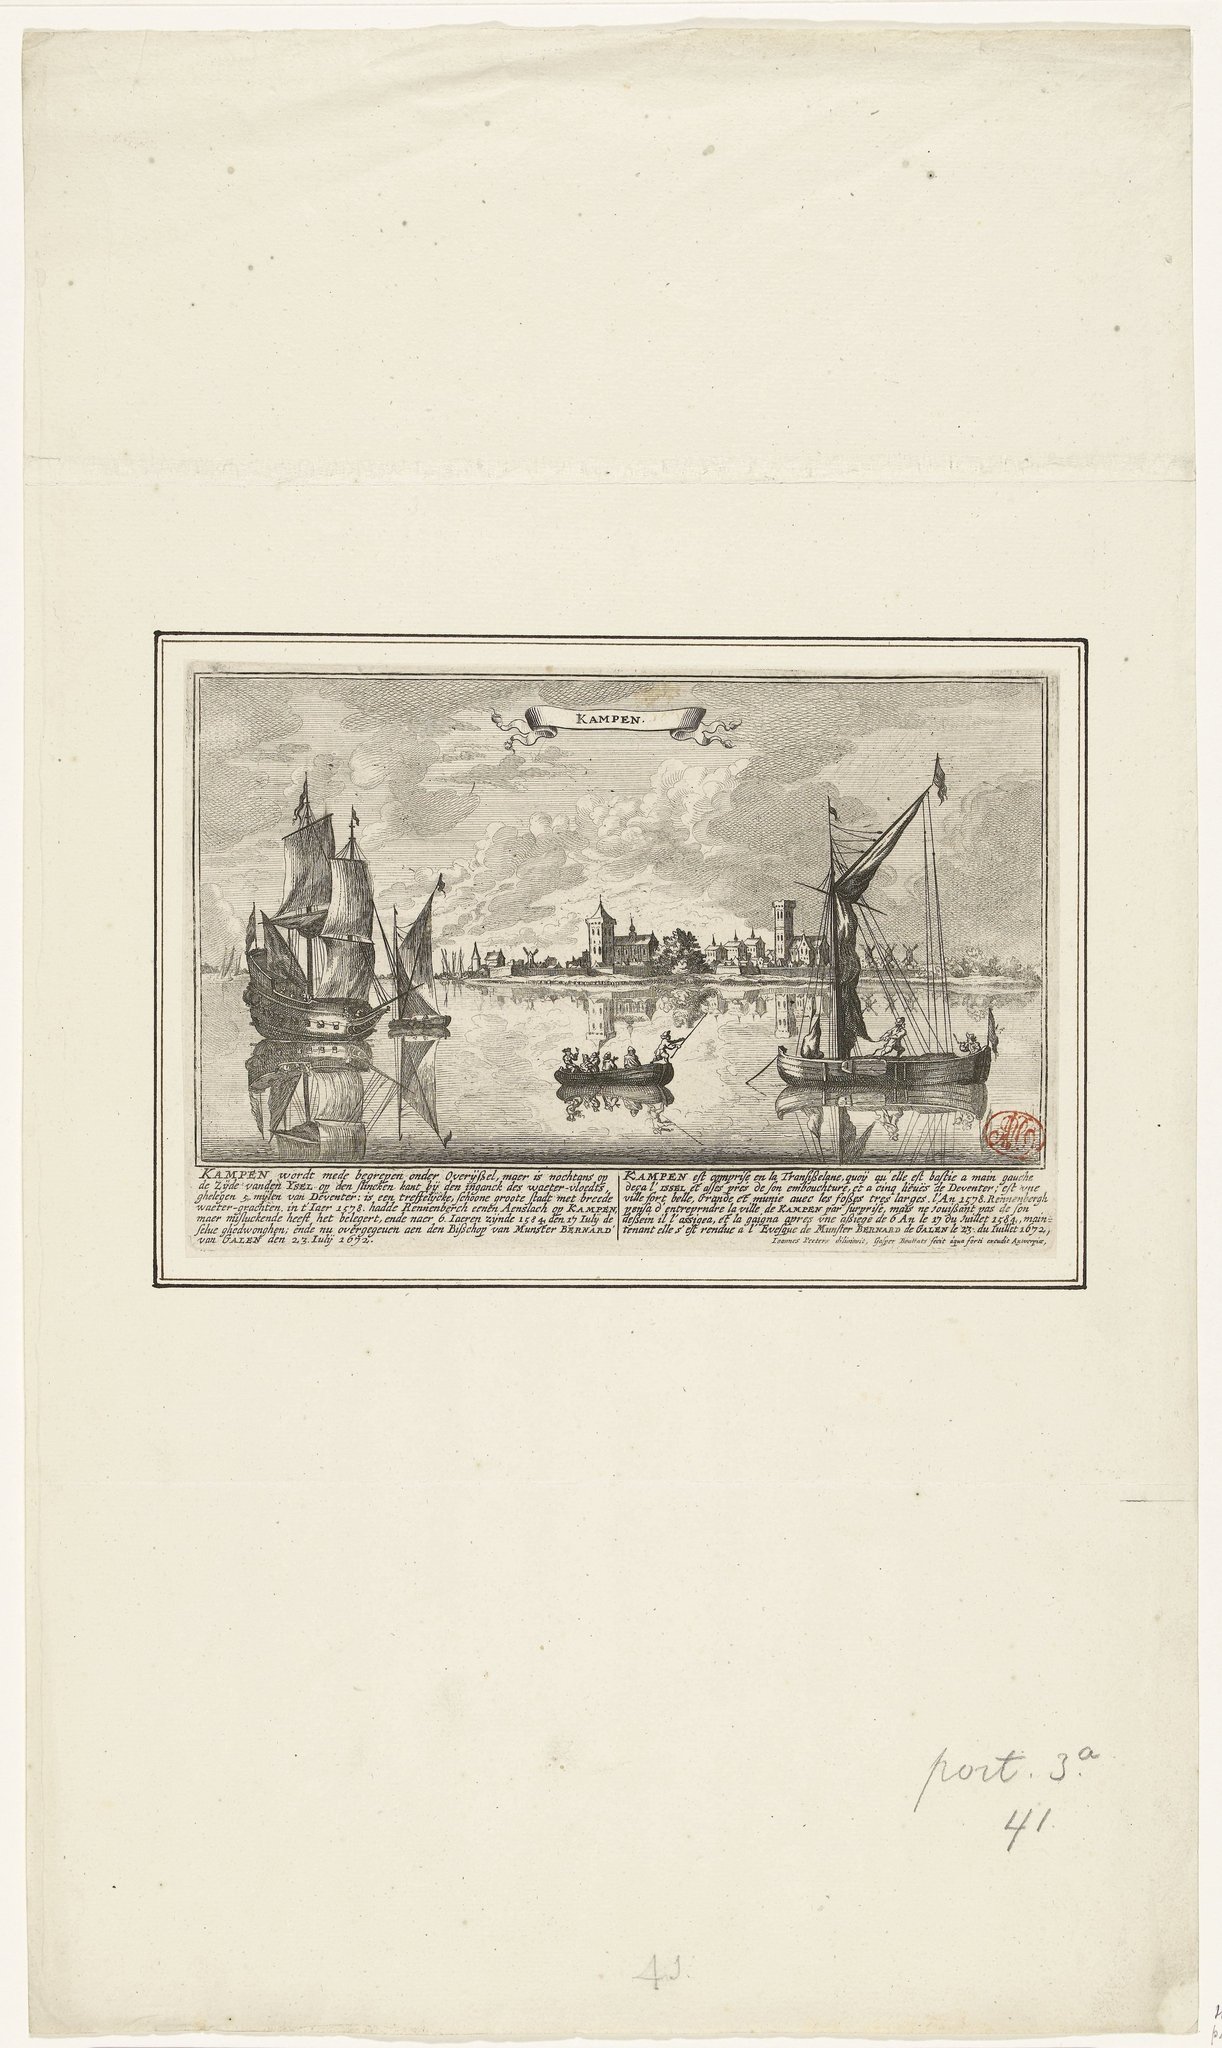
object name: print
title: Steden en vestigingen in de Republiek der Nederlanden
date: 1679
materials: paper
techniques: etching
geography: antwerp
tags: prospect of city, town panorama, silhouette of city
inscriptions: collector's mark: Lugt 195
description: Gezicht op de stad Kampen. Op de voorgrond, buiten de stadsmuren, de rivier De Ijsel met een galjoen en enkele zeilschepen. Boven het stadsgezicht een cartouche met de naam van de stad. De prent heeft een Nederlands en Frans onderschrift.